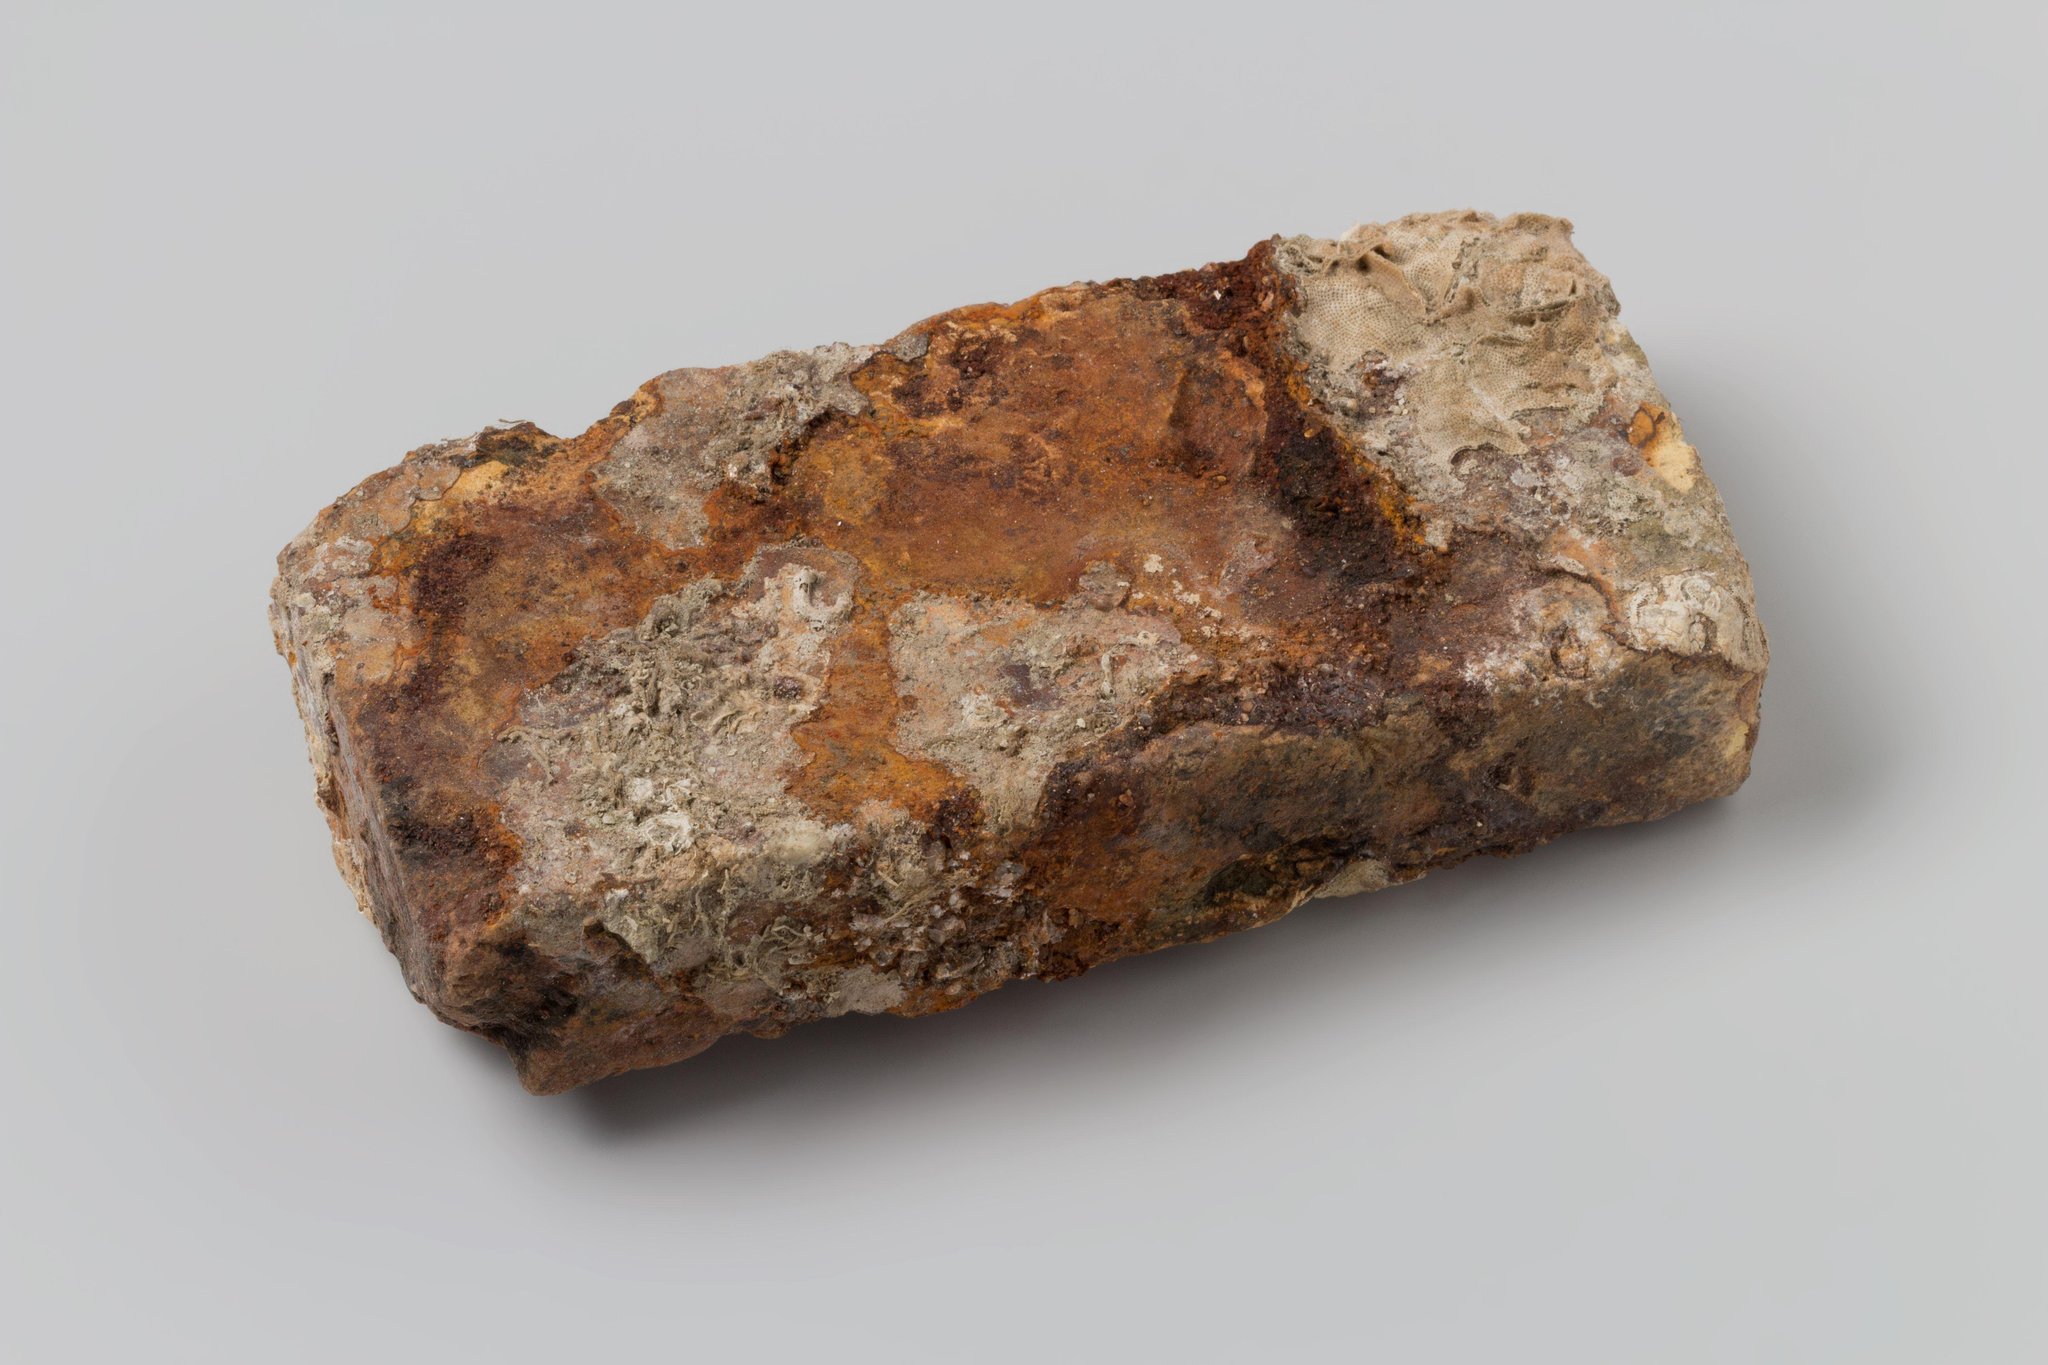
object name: brick clay product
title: Baksteen uit het wrak van de Oost-Indiëvaarder Hollandia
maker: Anonymous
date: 1700-1743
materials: brick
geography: netherlands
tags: verenigde oostindische compagnie, hollandia (schip), annet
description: Constructional elements, brick; sim. NG 1980-27H1009.